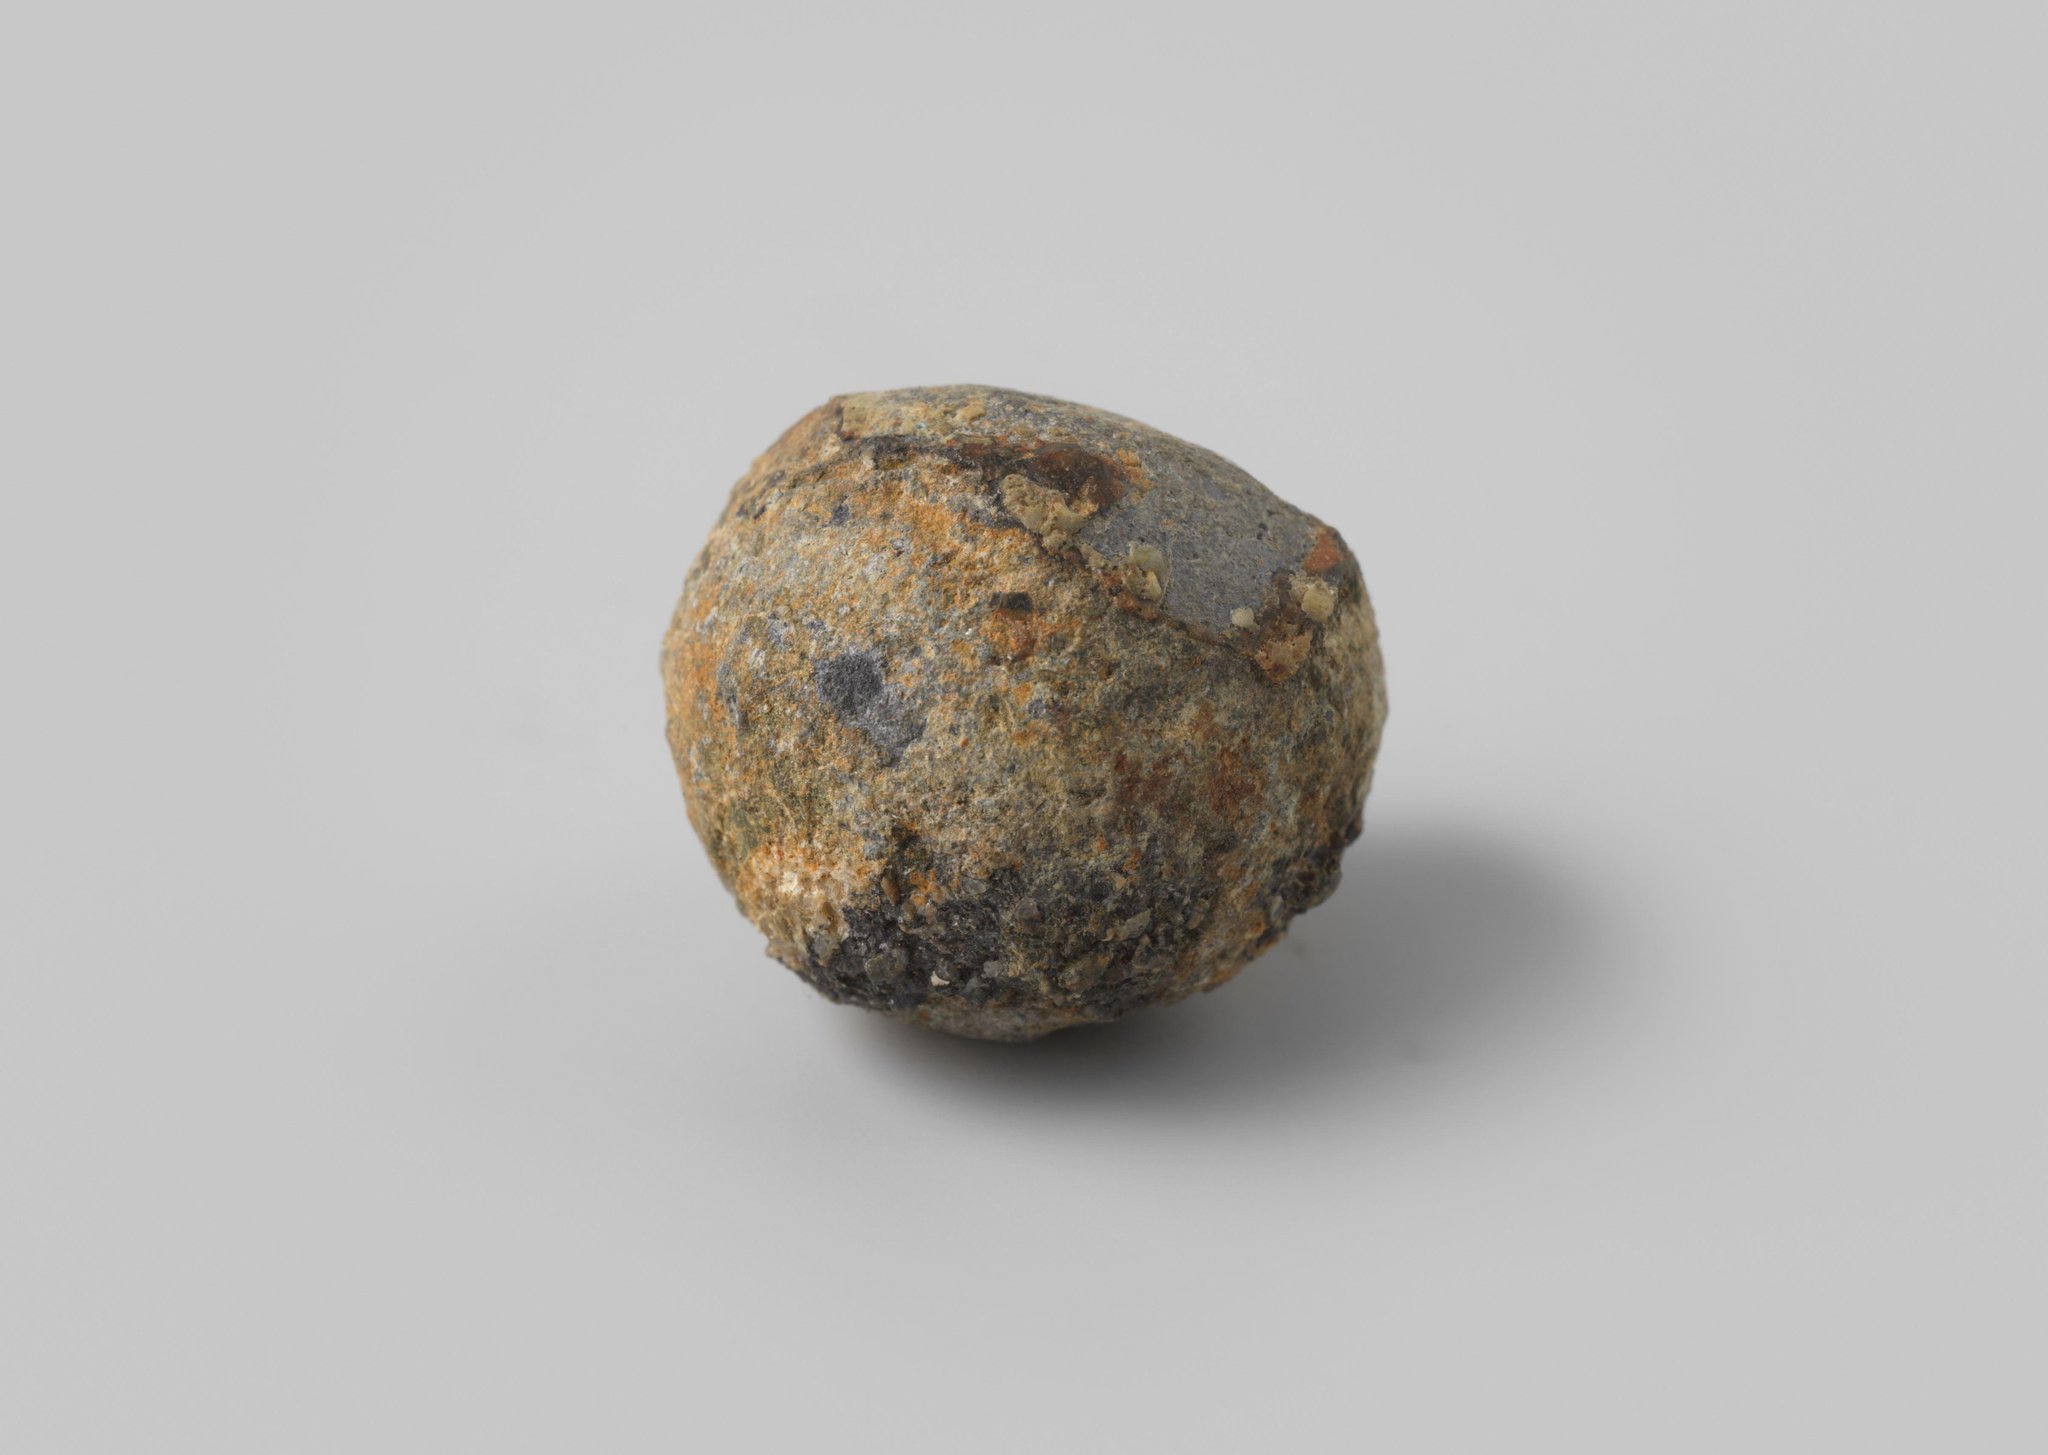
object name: musketkogel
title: Musketkogel uit het wrak van de Oost-Indiëvaarder Hollandia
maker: Anonymous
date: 1700-1743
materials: lead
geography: netherlands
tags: verenigde oostindische compagnie, hollandia (schip), annet